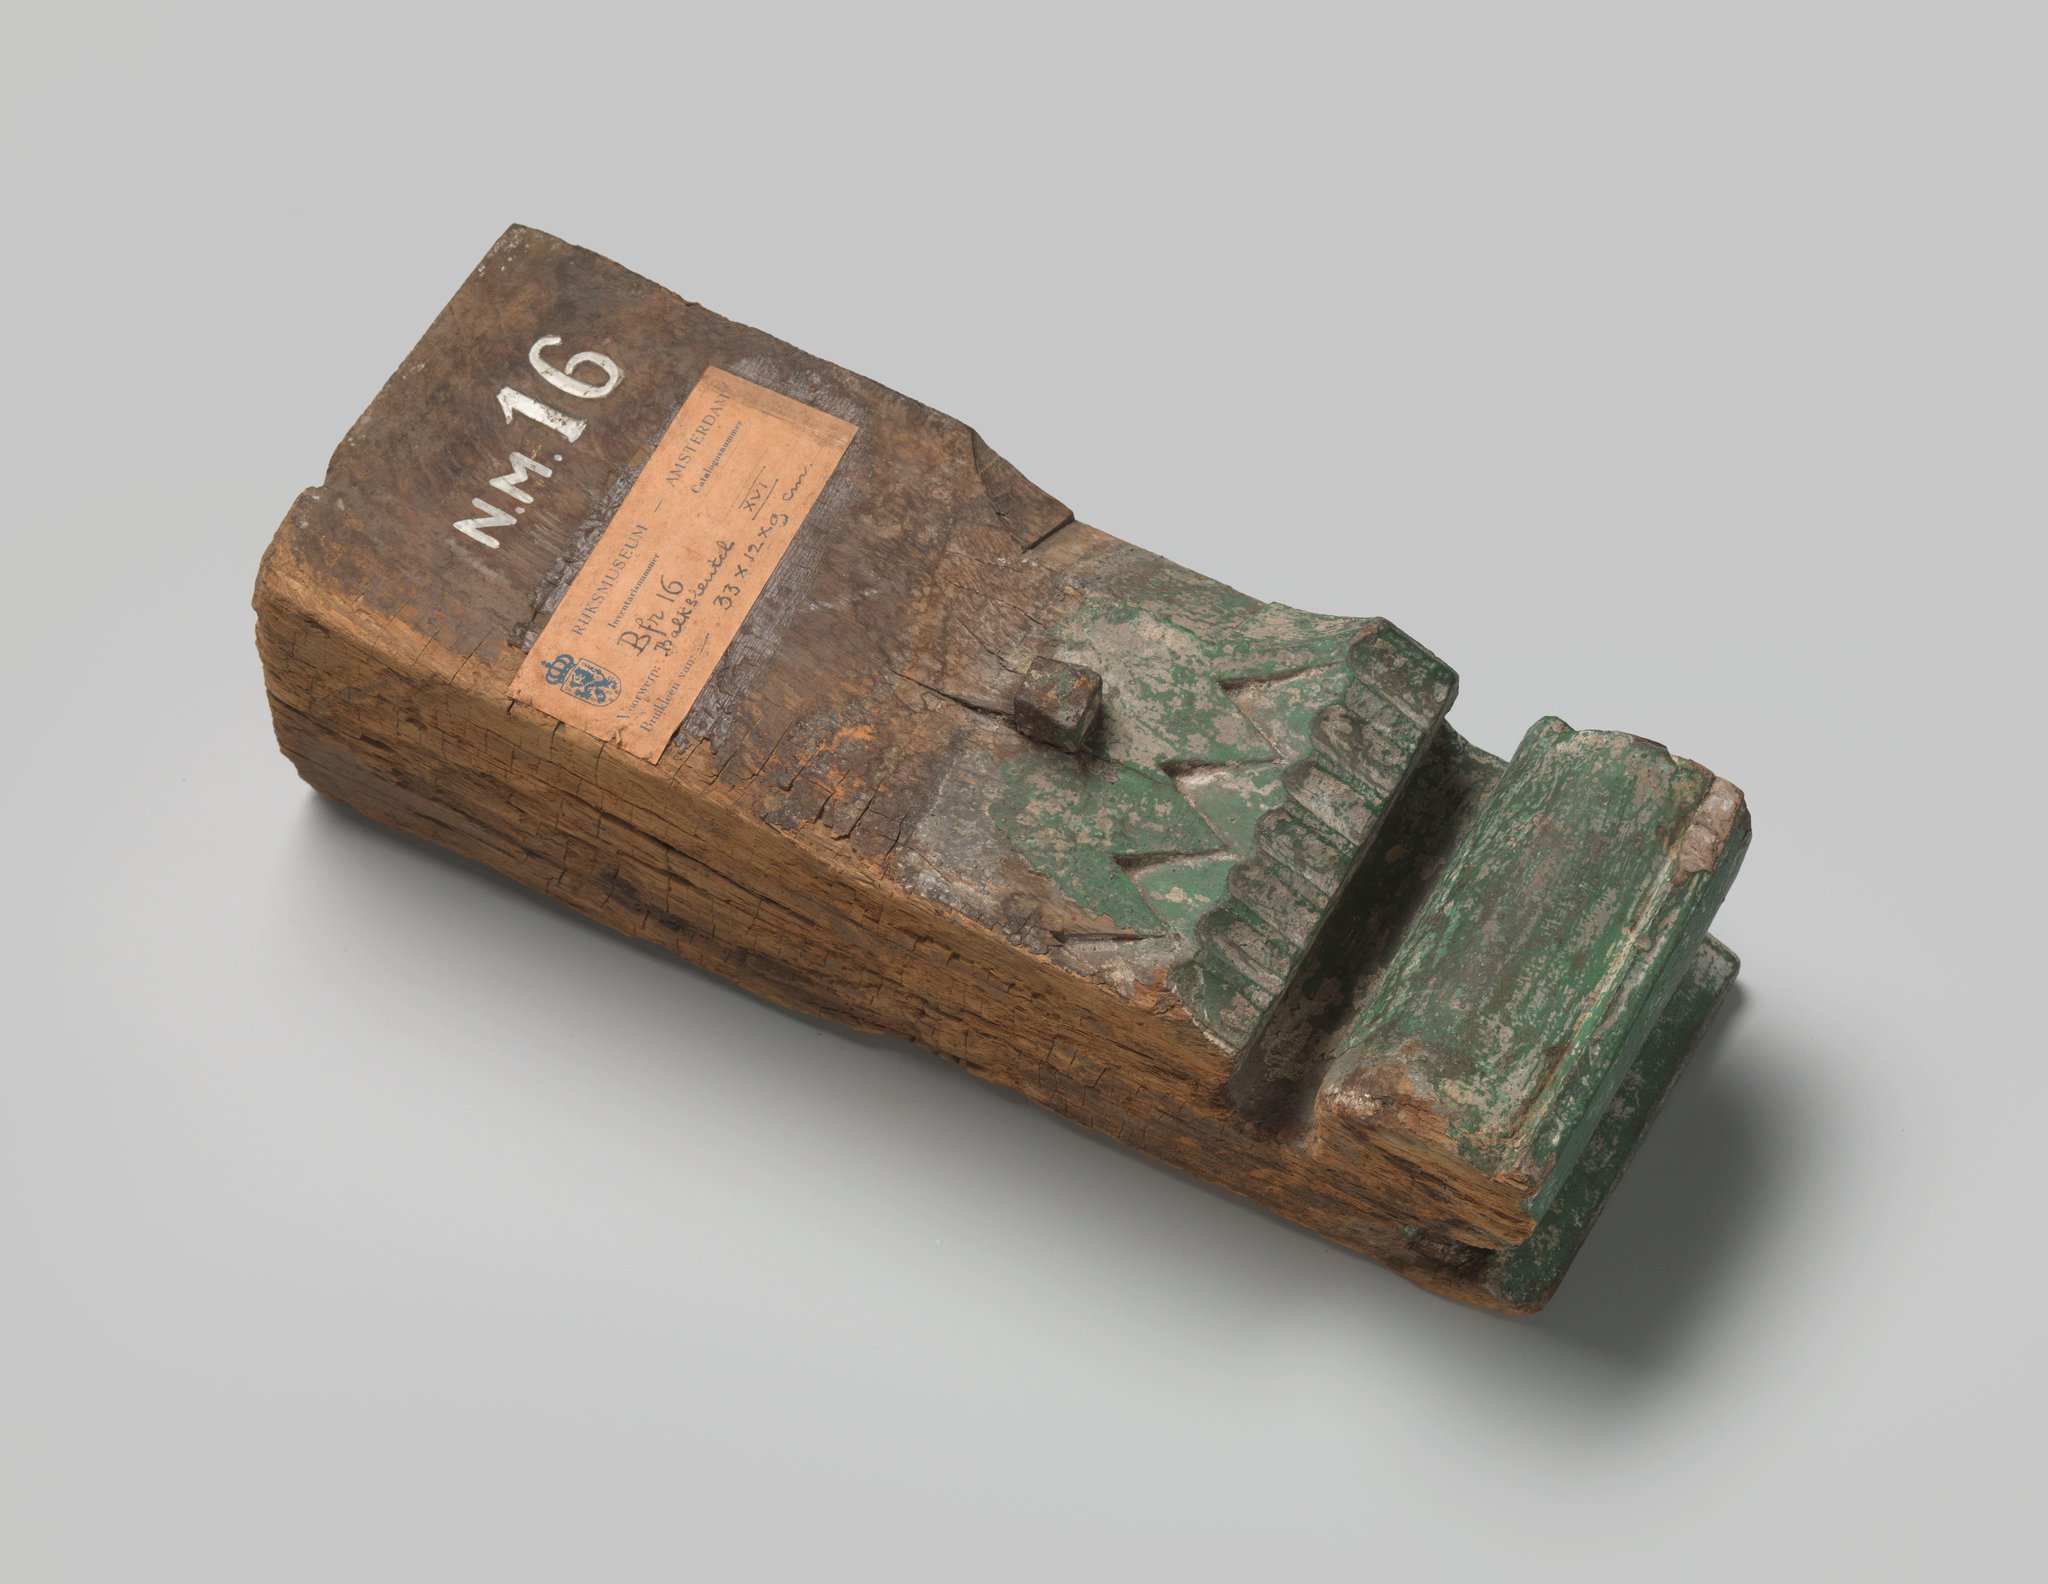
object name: architectural element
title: Sleutelstuk met gotisch lijstwerk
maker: Anonymous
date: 1400-1950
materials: iron, wood, paint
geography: northern netherlands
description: Sleutelstuk van eikenhout met gotisch lijstwerk.